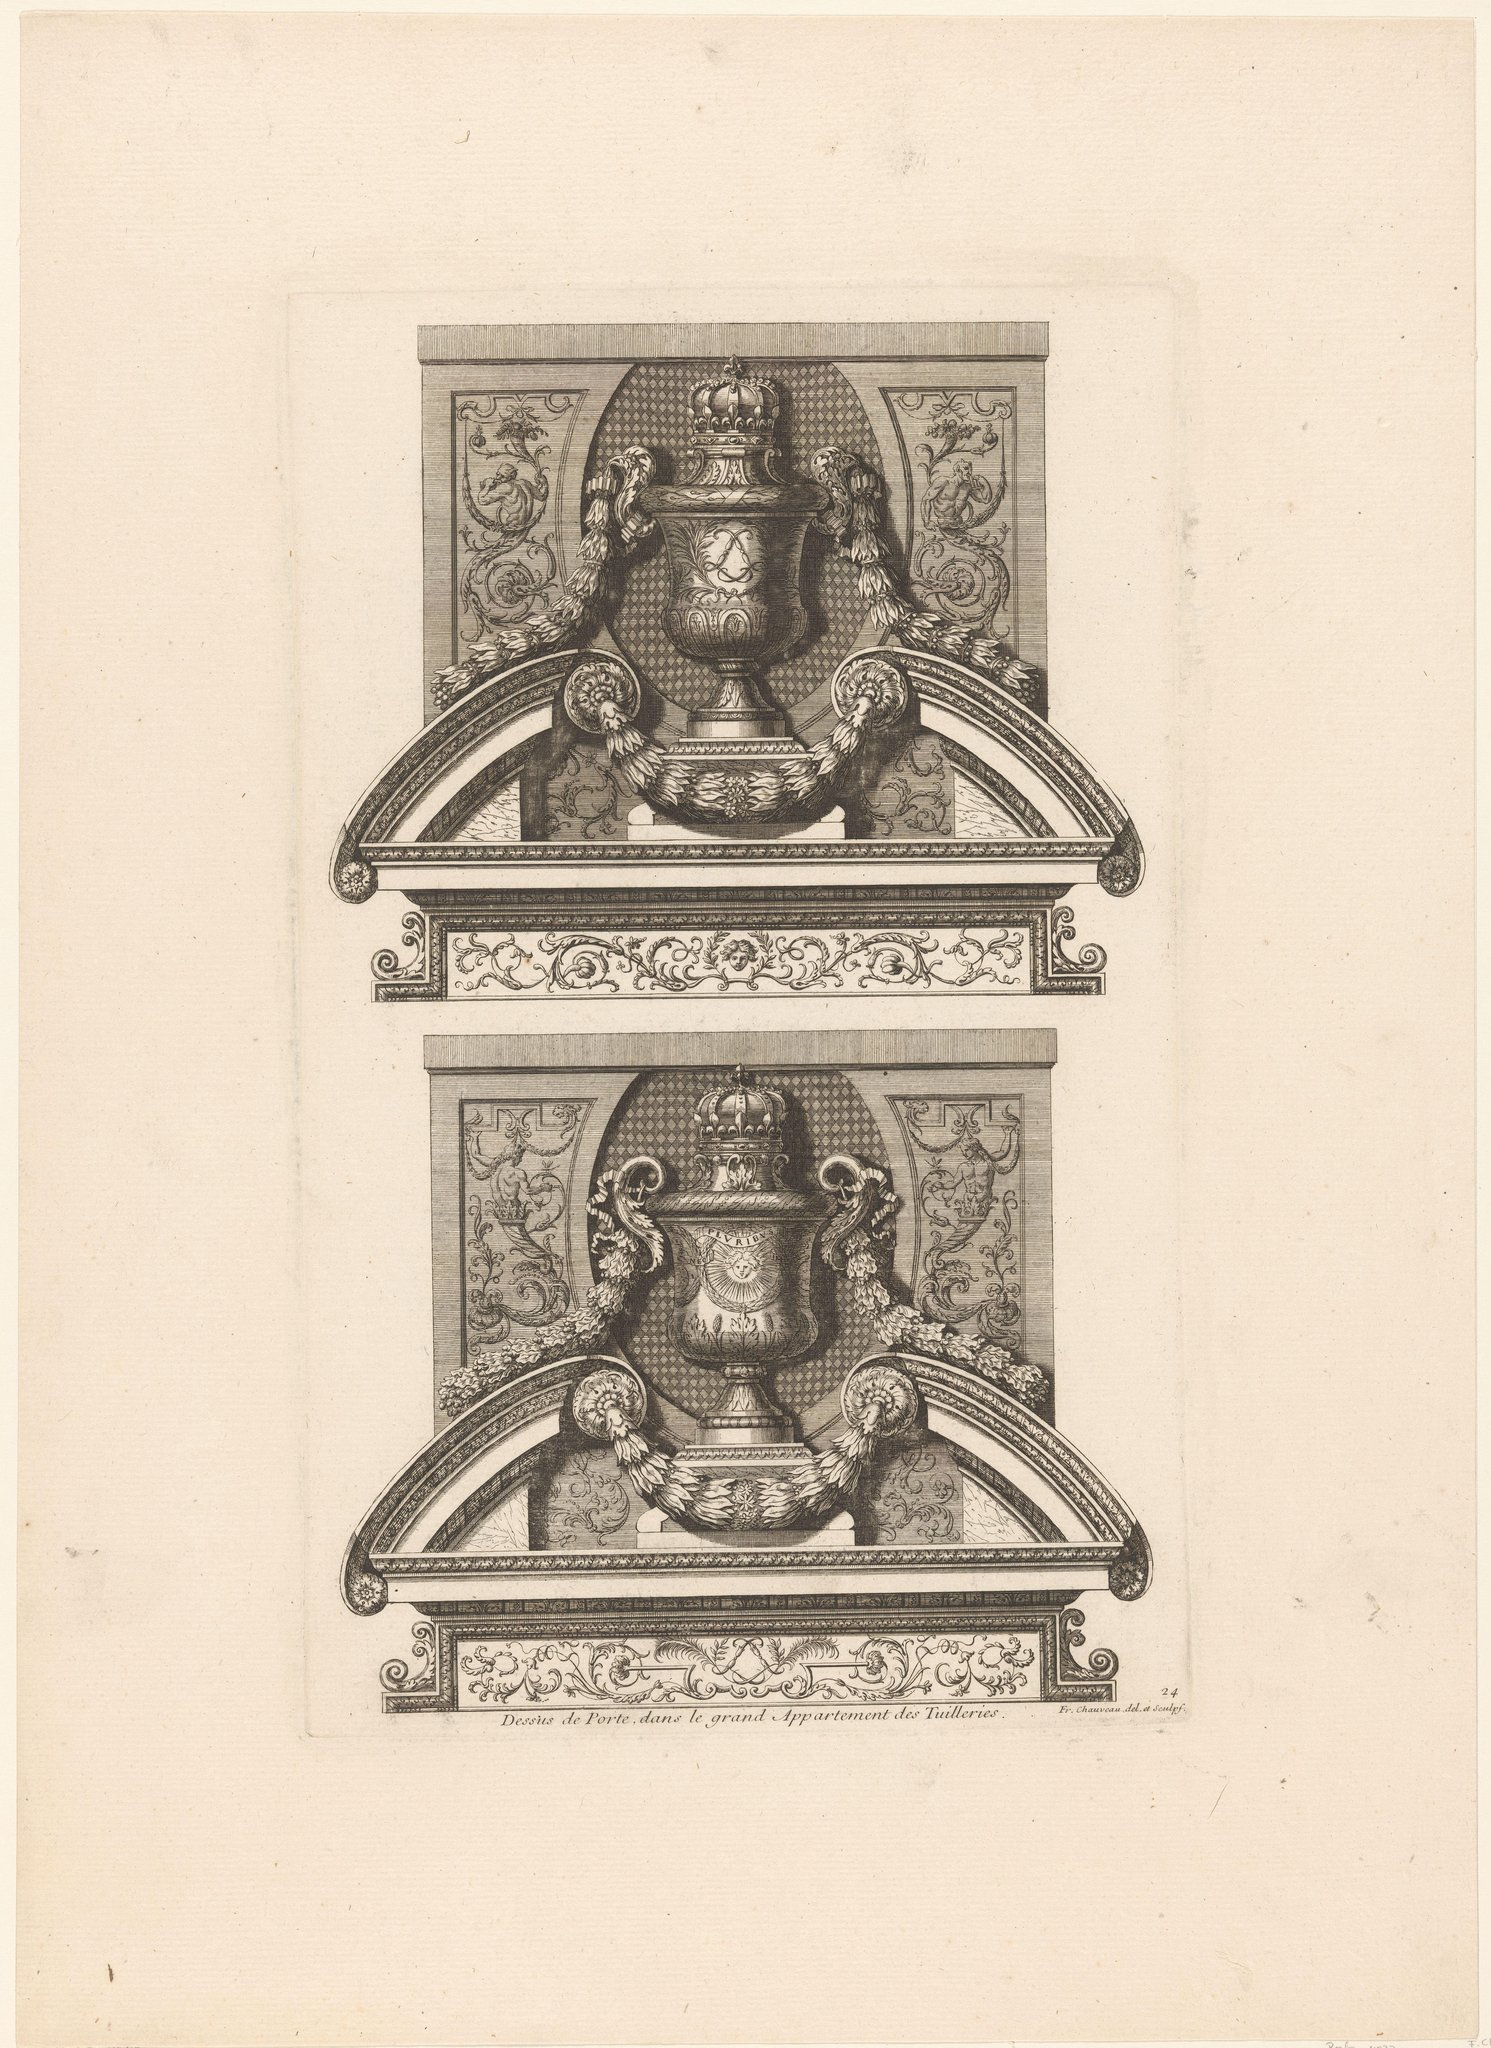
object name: print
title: Dessus de Porte, dans le grand Appartement des Tuilleries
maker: françois chauveau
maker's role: draughtsman, painter, print maker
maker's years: 1613-1676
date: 1670-1676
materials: paper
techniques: etching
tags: vase ~ ornament, door, tuileries palace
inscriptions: collector's mark: Lugt 2228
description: Elf prenten van Jean Bérain le Vieux (RP-P-OB-9624 t/m 9634), dertien prenten van François Chauveau (RP-P-OB-9635 t/m 9647), vier prenten van Lemoine (RP-P-OB-9674 t/m 9677) en een titelprent (in 1710 toegevoegd) vormen tezamen een serie van 29.